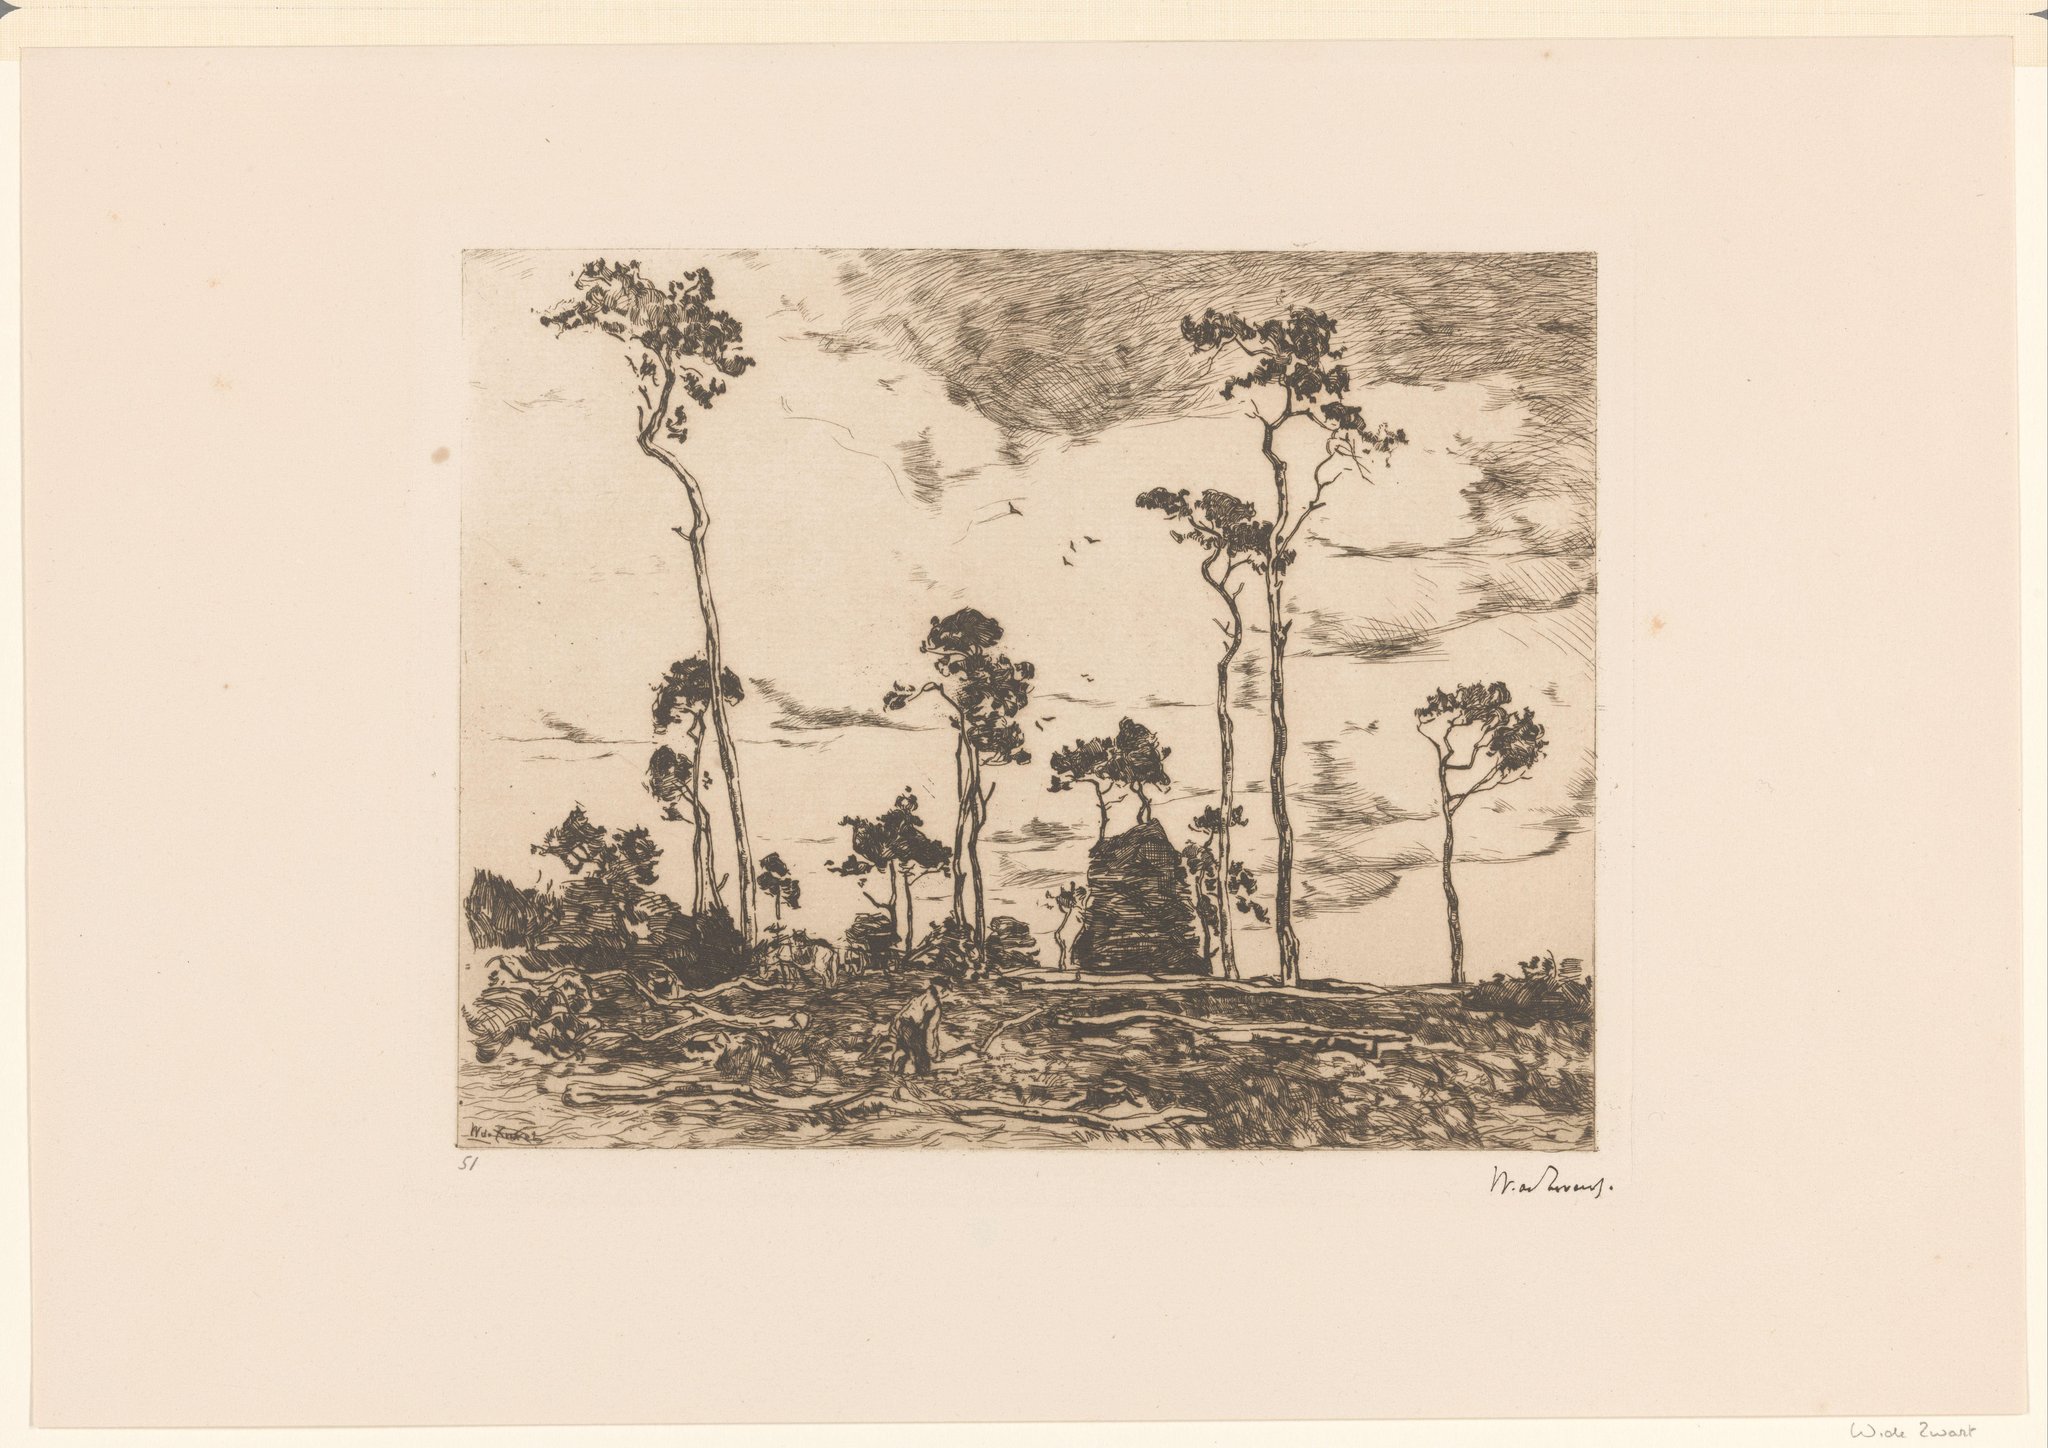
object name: print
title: Hakhout laden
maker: willem de zwart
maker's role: draughtsman, painter, print maker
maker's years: 1862-1931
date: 1896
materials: paper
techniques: etching, intaglio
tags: forester, trees, (farm) wagon, freight wagon, cart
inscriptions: collector's mark: Lugt 2760, collector's mark: Lugt 2228